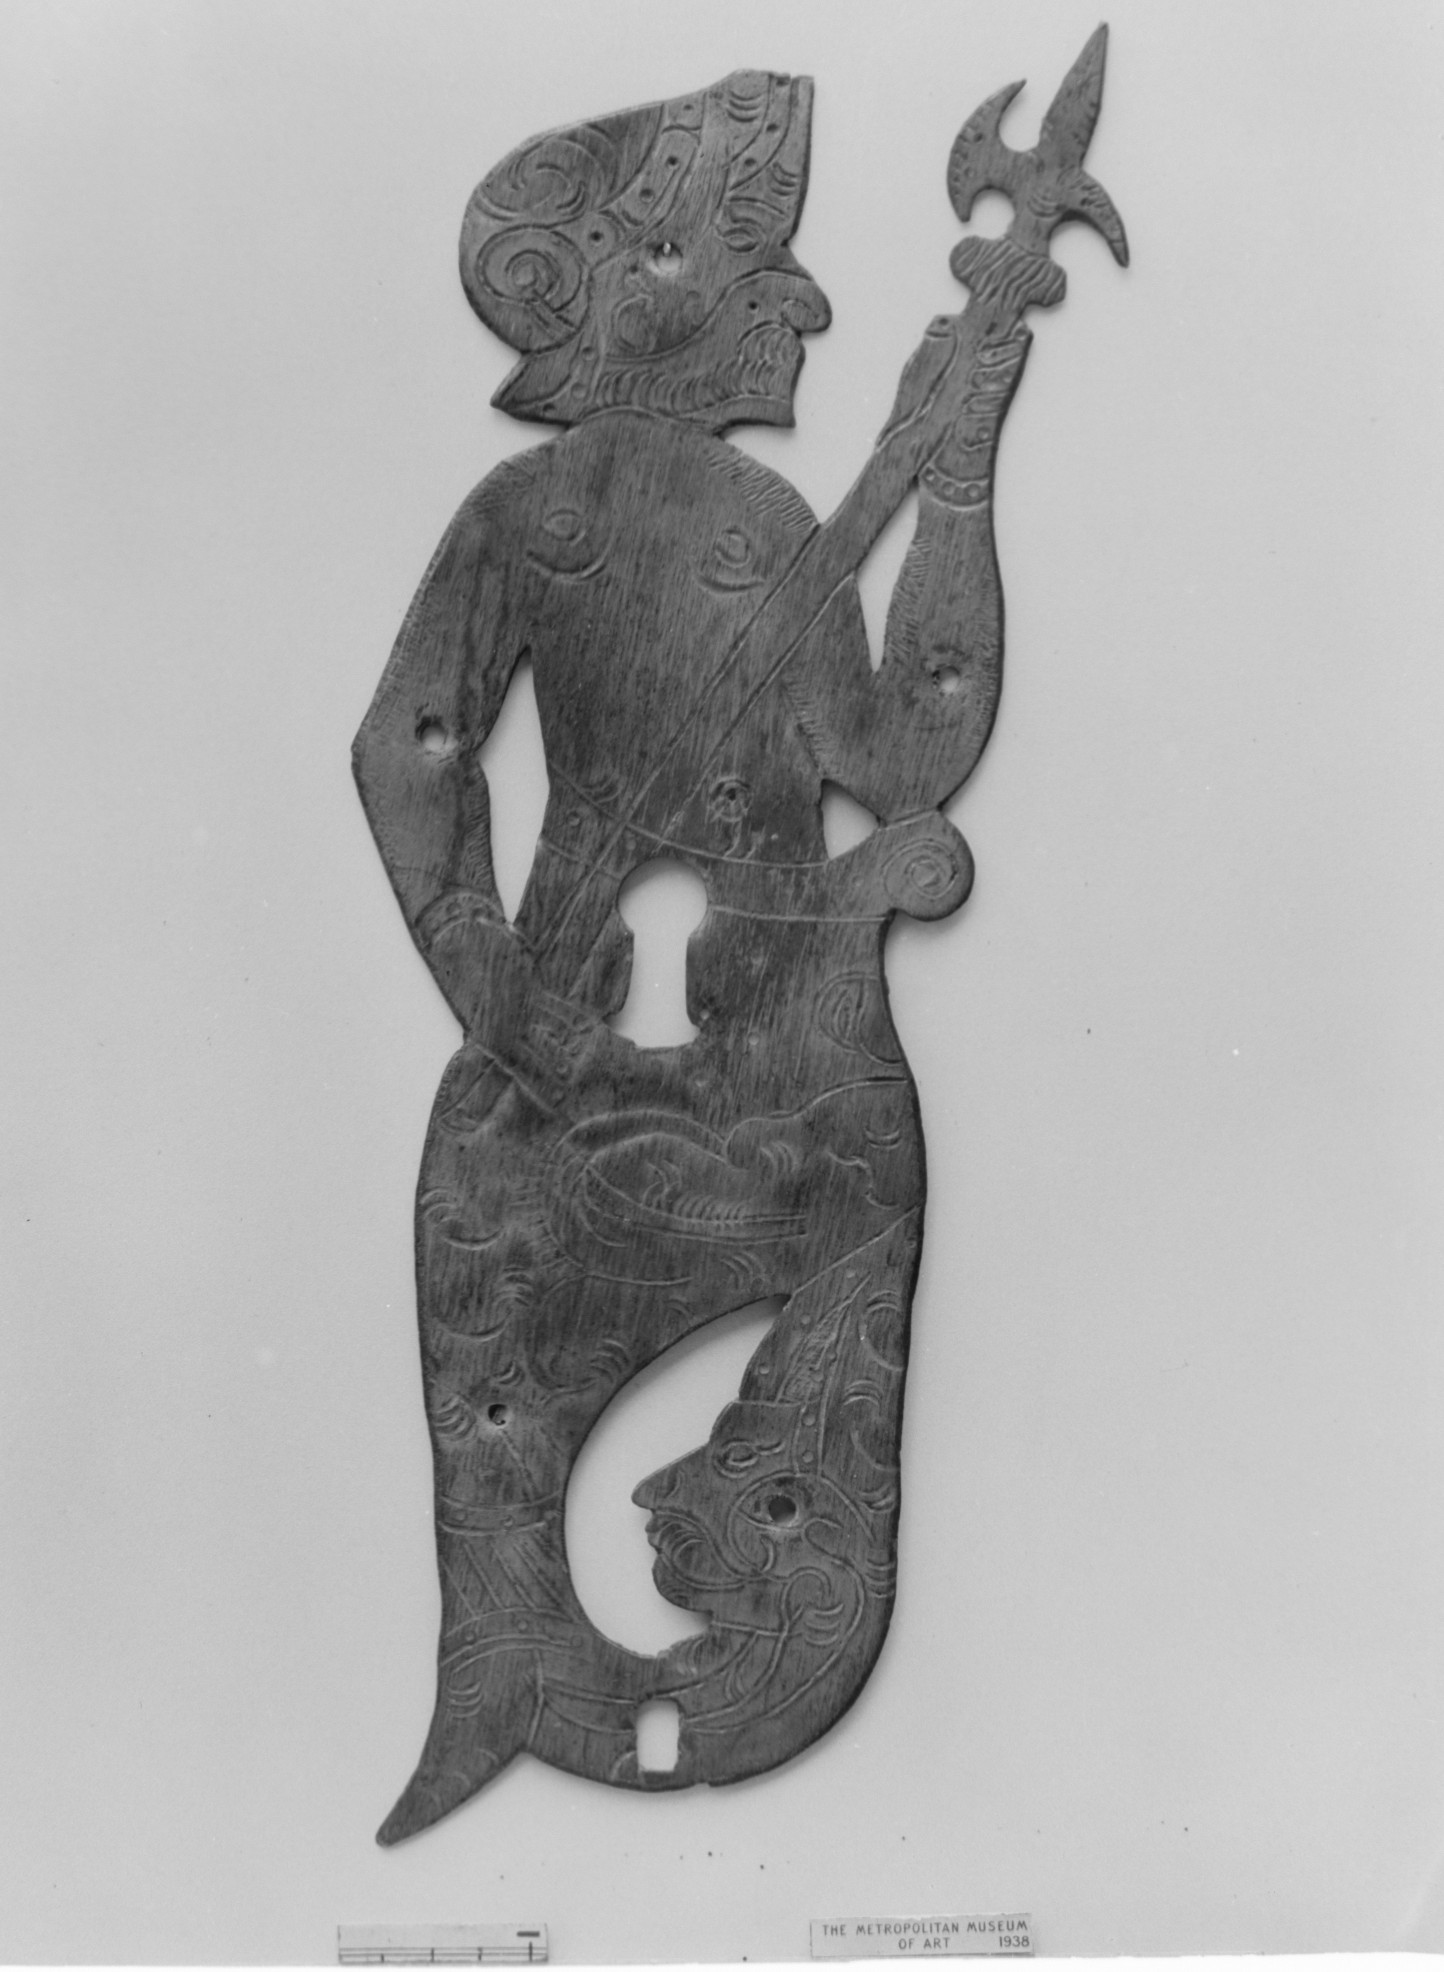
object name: escutcheon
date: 1601-1700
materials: iron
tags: human figures,axes